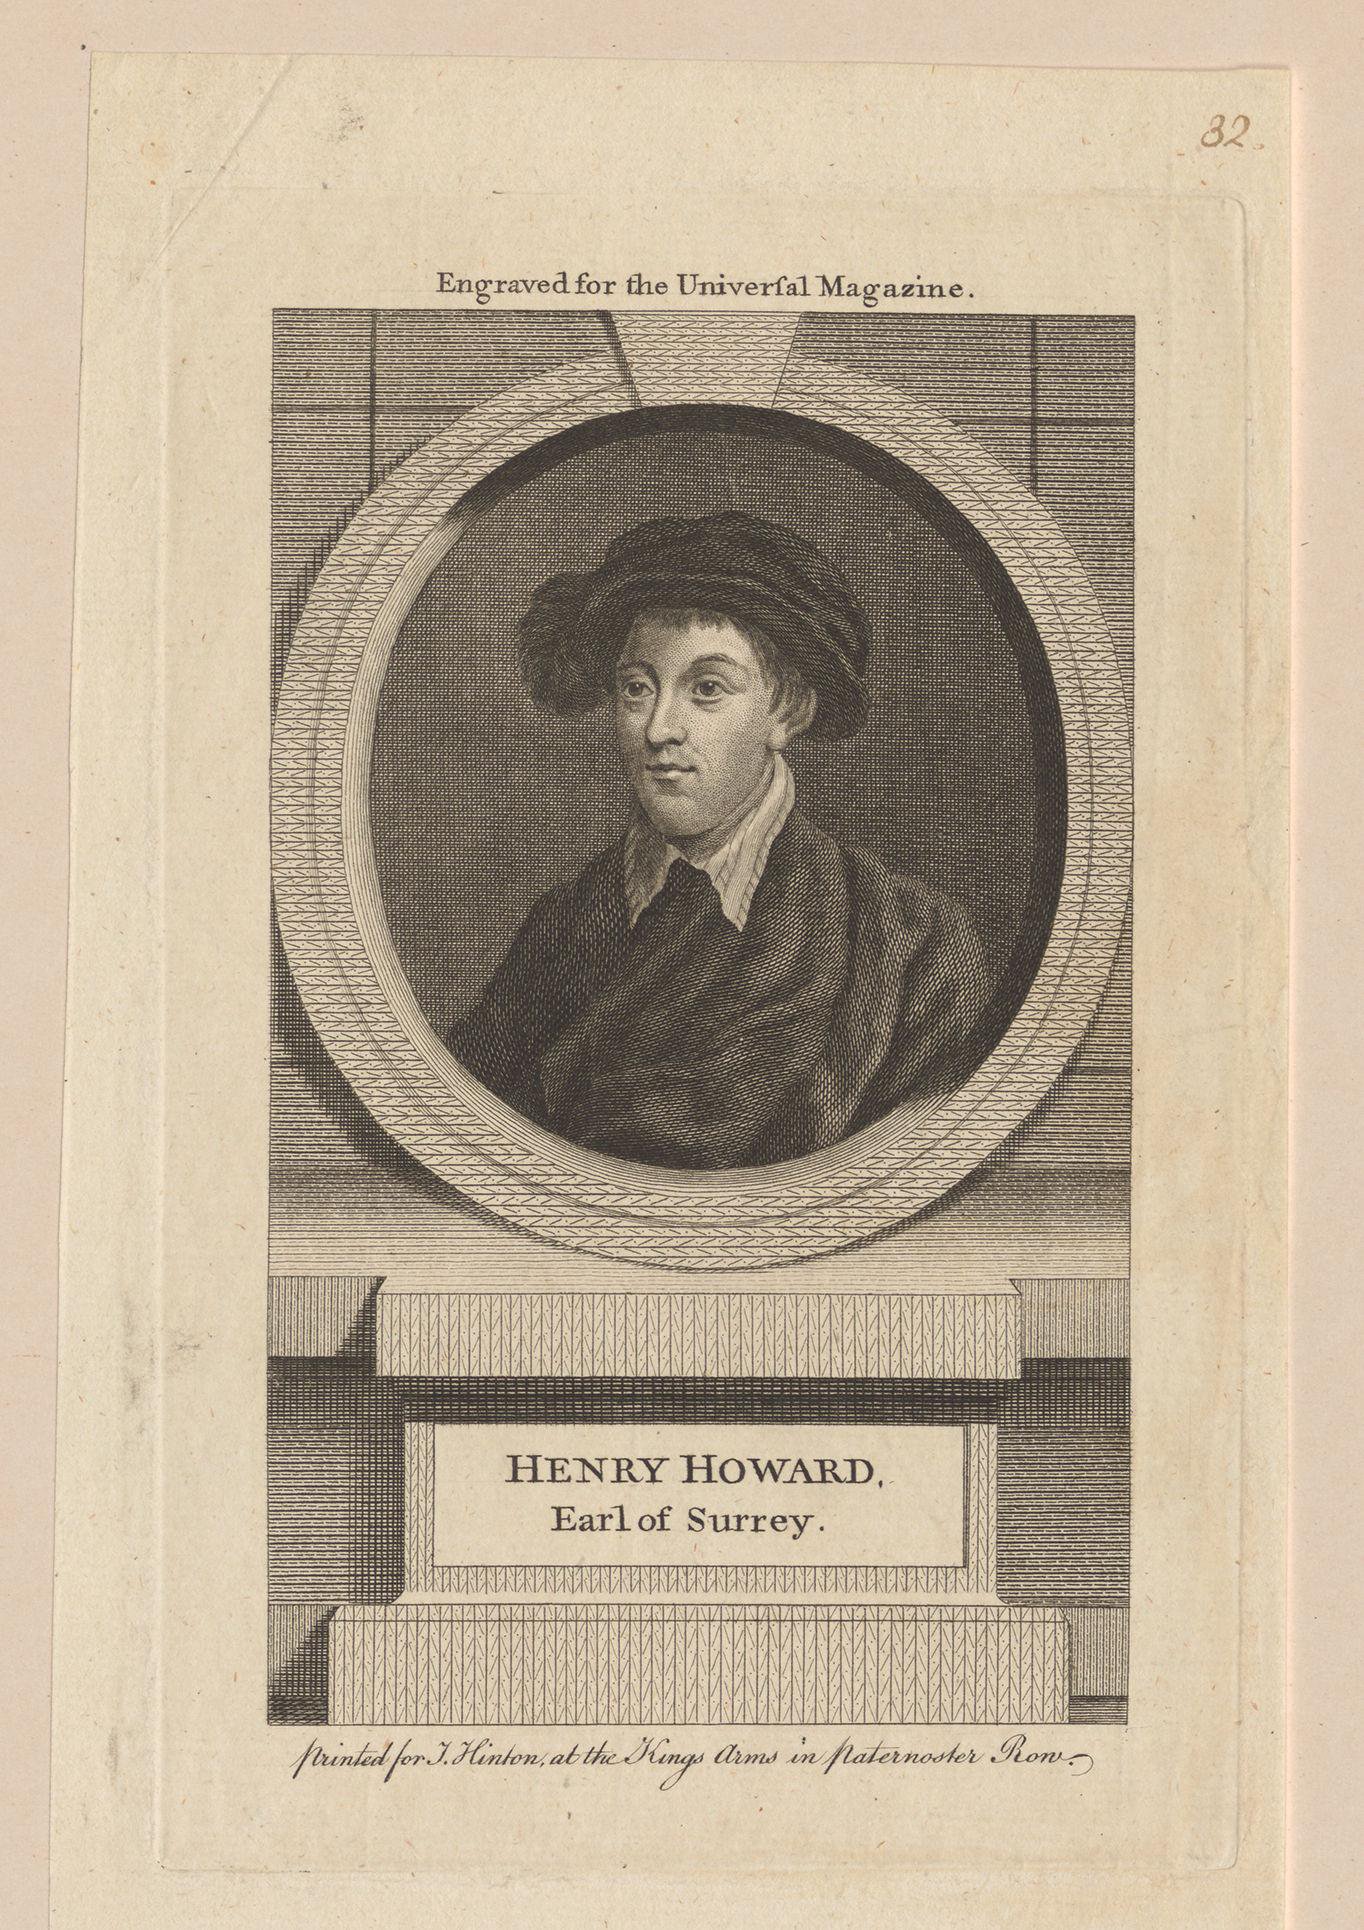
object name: print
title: Portret van Henry Howard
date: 1778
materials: paper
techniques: engraving, etching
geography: london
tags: london, historical persons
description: Prent waarschijnlijk uit: The Universal Magazine of Knowledge and Pleasure (...) Londen: John Hinton, 1778, dl 63, p. 56.